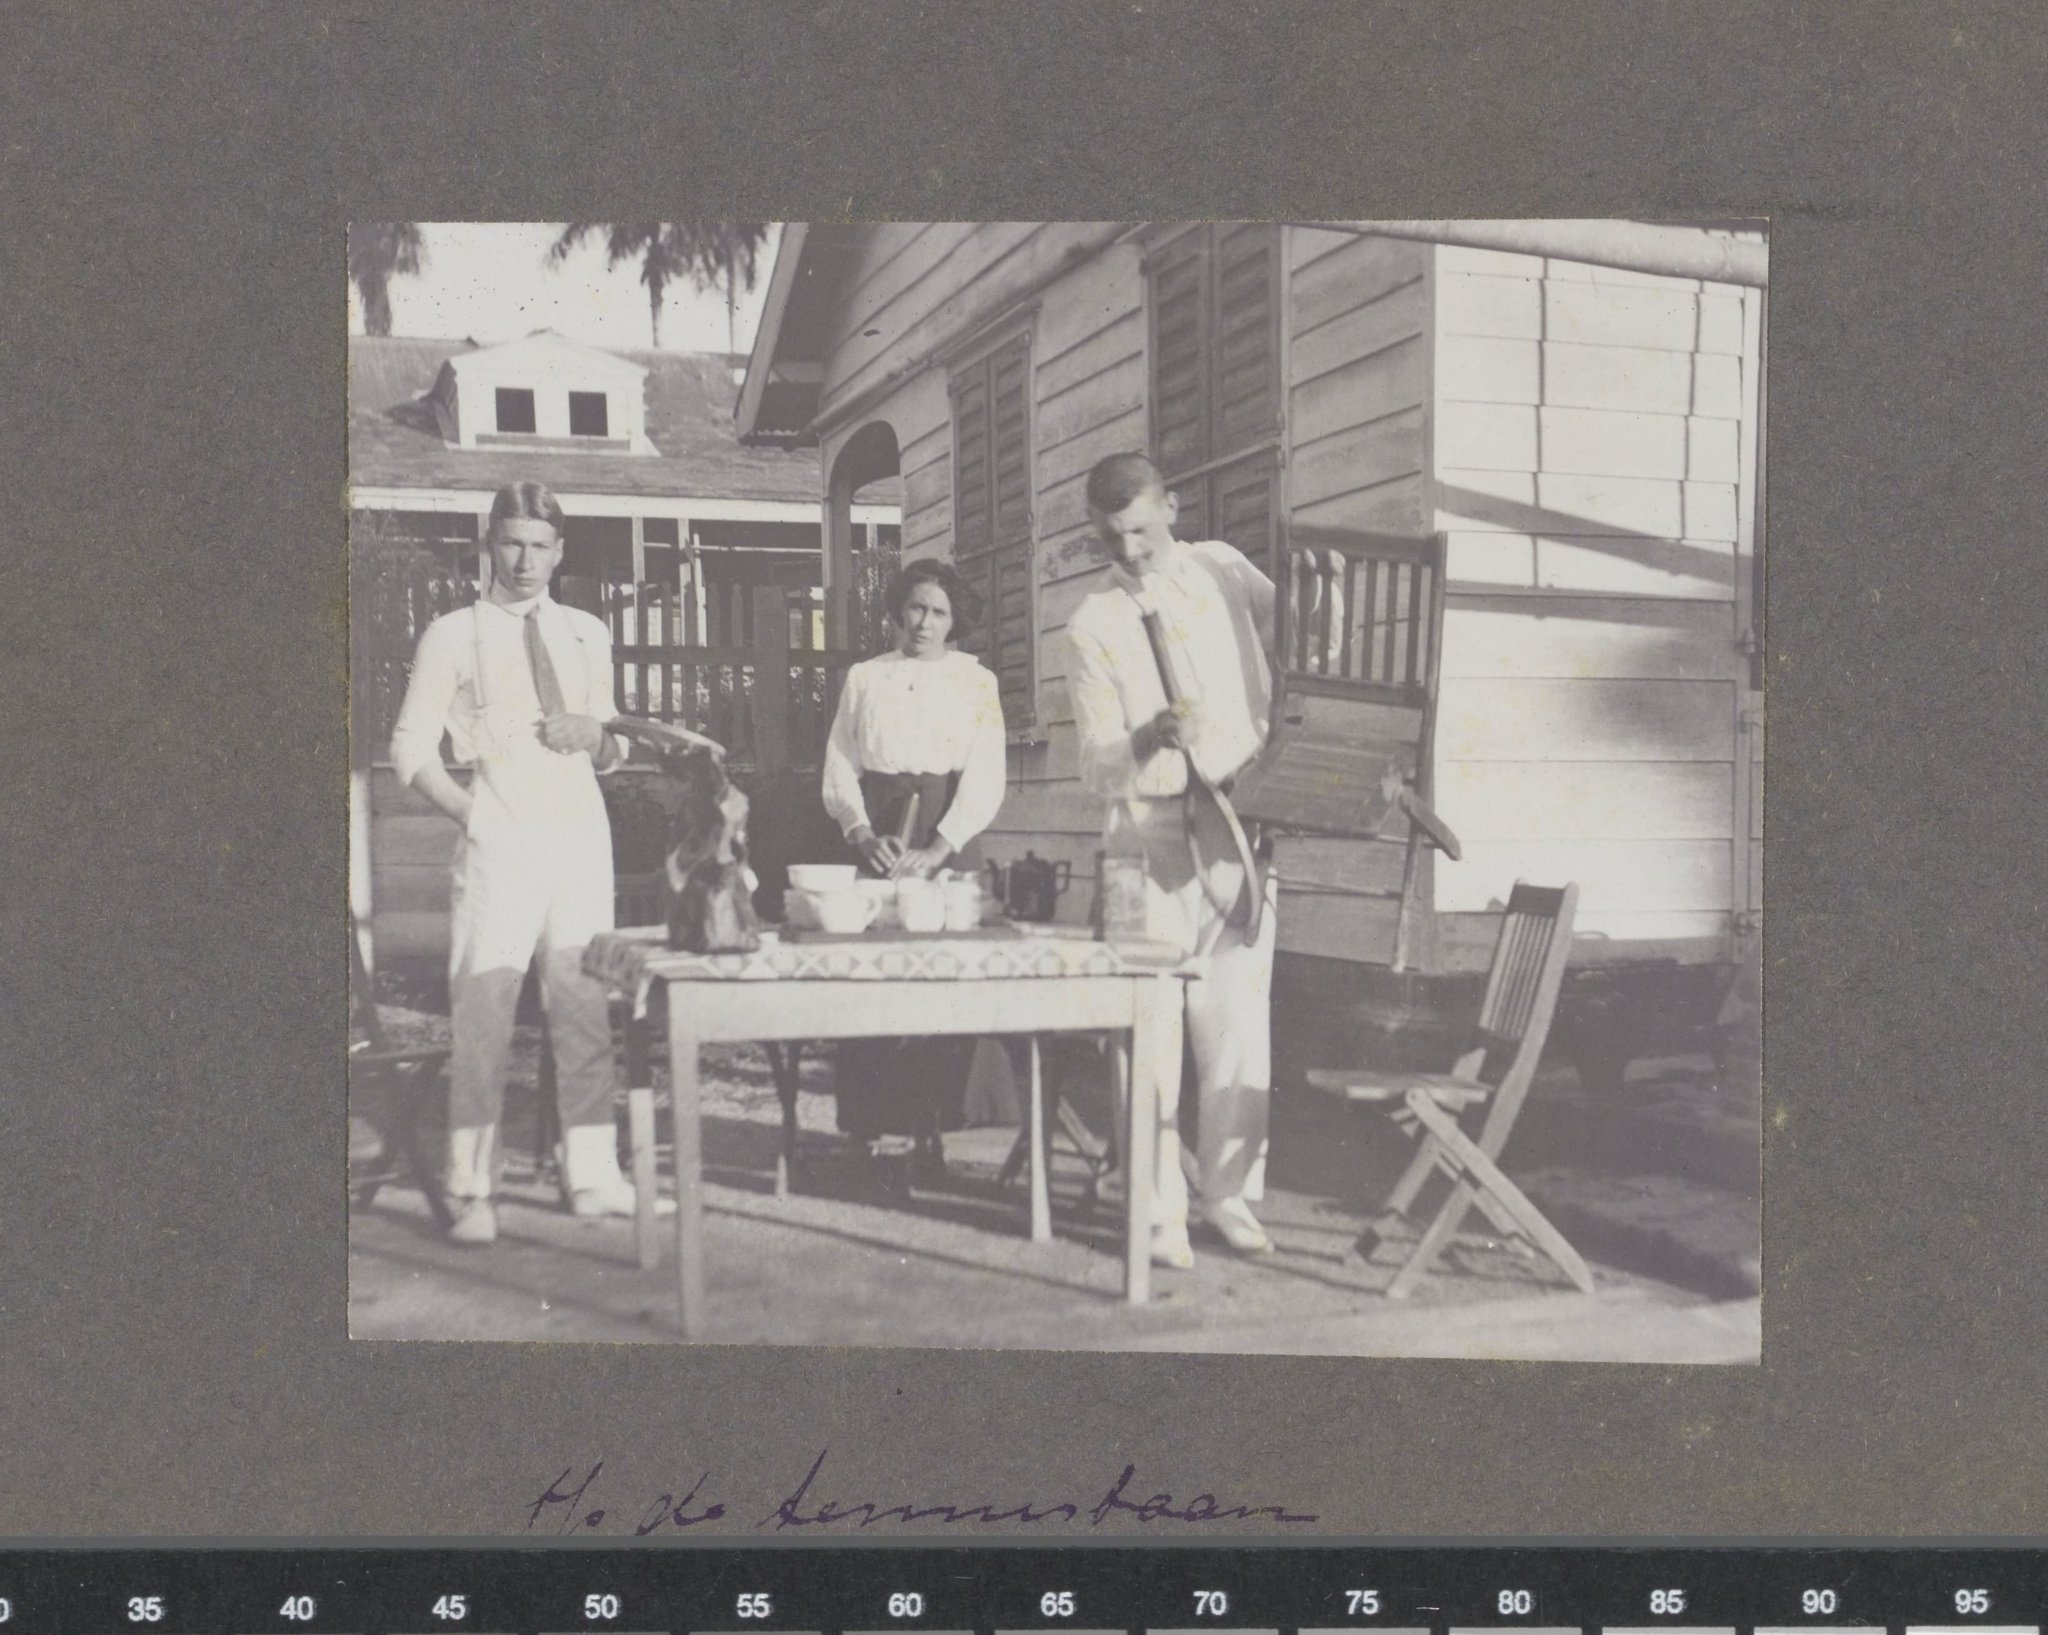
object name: photograph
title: Op de tennisbaan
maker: Anonymous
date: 1909-1911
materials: photographic support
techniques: photography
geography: suriname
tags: tennis, lawn-tennis, suriname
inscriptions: inscription: ‘Op de tennisbaan’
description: Maria Gonggrijp tussen twee mannen bij het clubhuis van de tennisbaan te Paramaribo. De linker man aangeduid als 'Oom Daan Boom', de rechter (elders) als 'van der Pullen', september 1911. Onderdeel van het fotoalbum over het leven van de familie Gonggrijp in Suriname rond 1912.